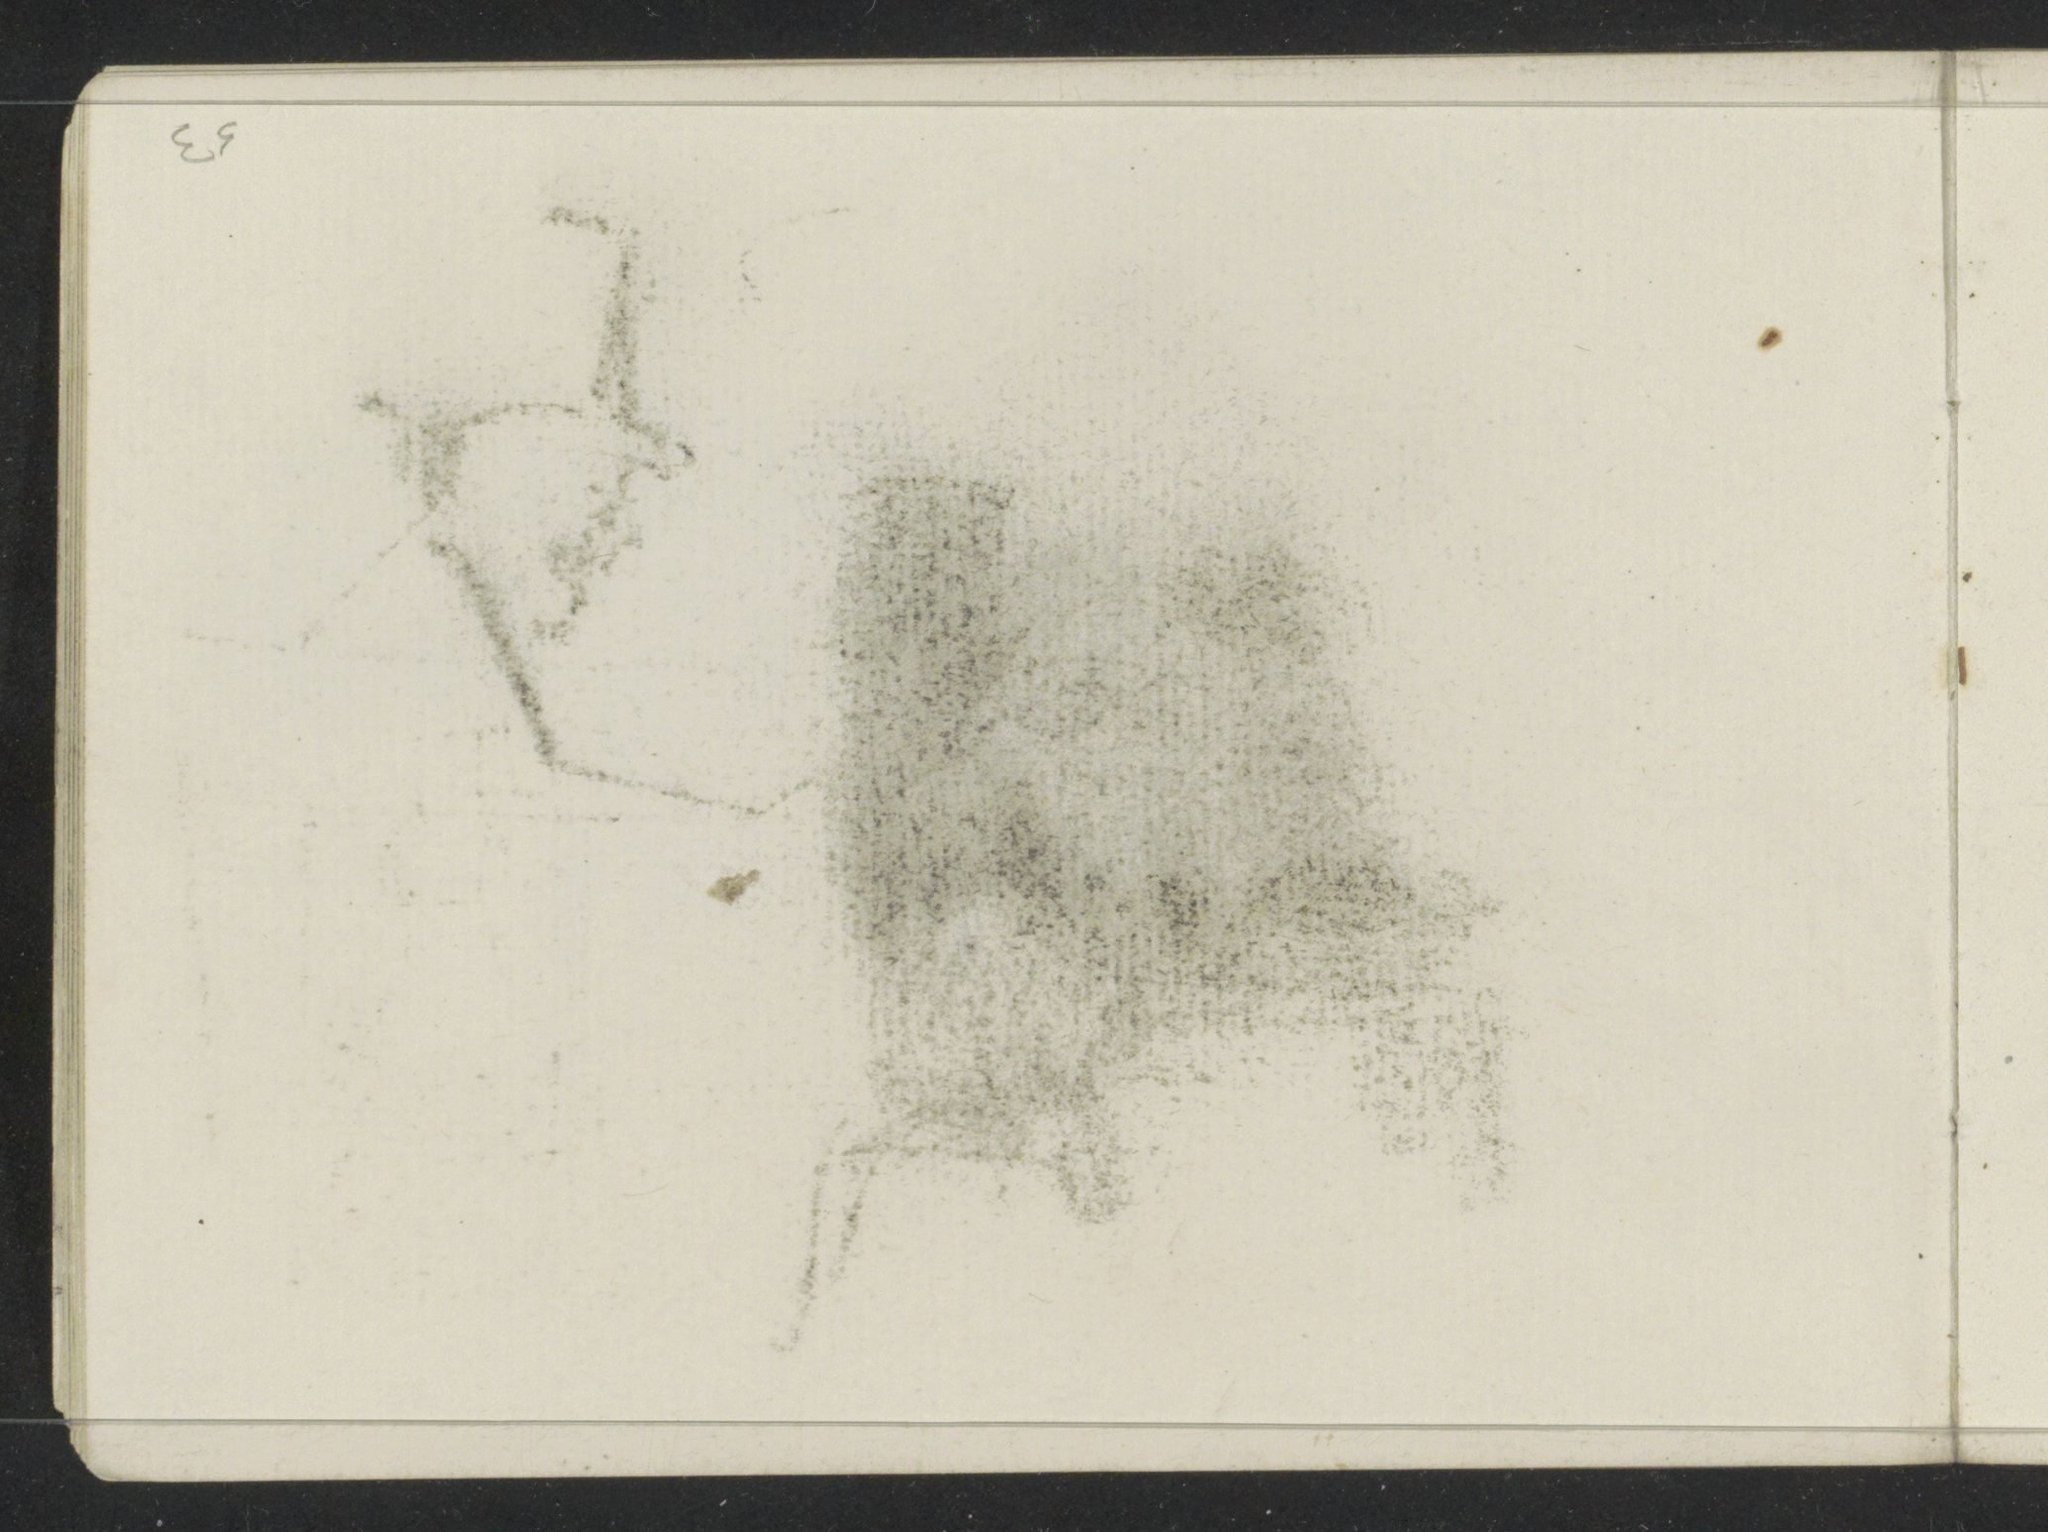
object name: sketchbook leaf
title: Abklatsch van de krijttekening op blad 7 recto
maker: isaac israels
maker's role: draughtsman, painter, print maker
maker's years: 1865-1934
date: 1886-1934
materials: paper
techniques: printmaking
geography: amsterdam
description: Blad 6 verso uit schetsboek LXIV met 29 bladen.